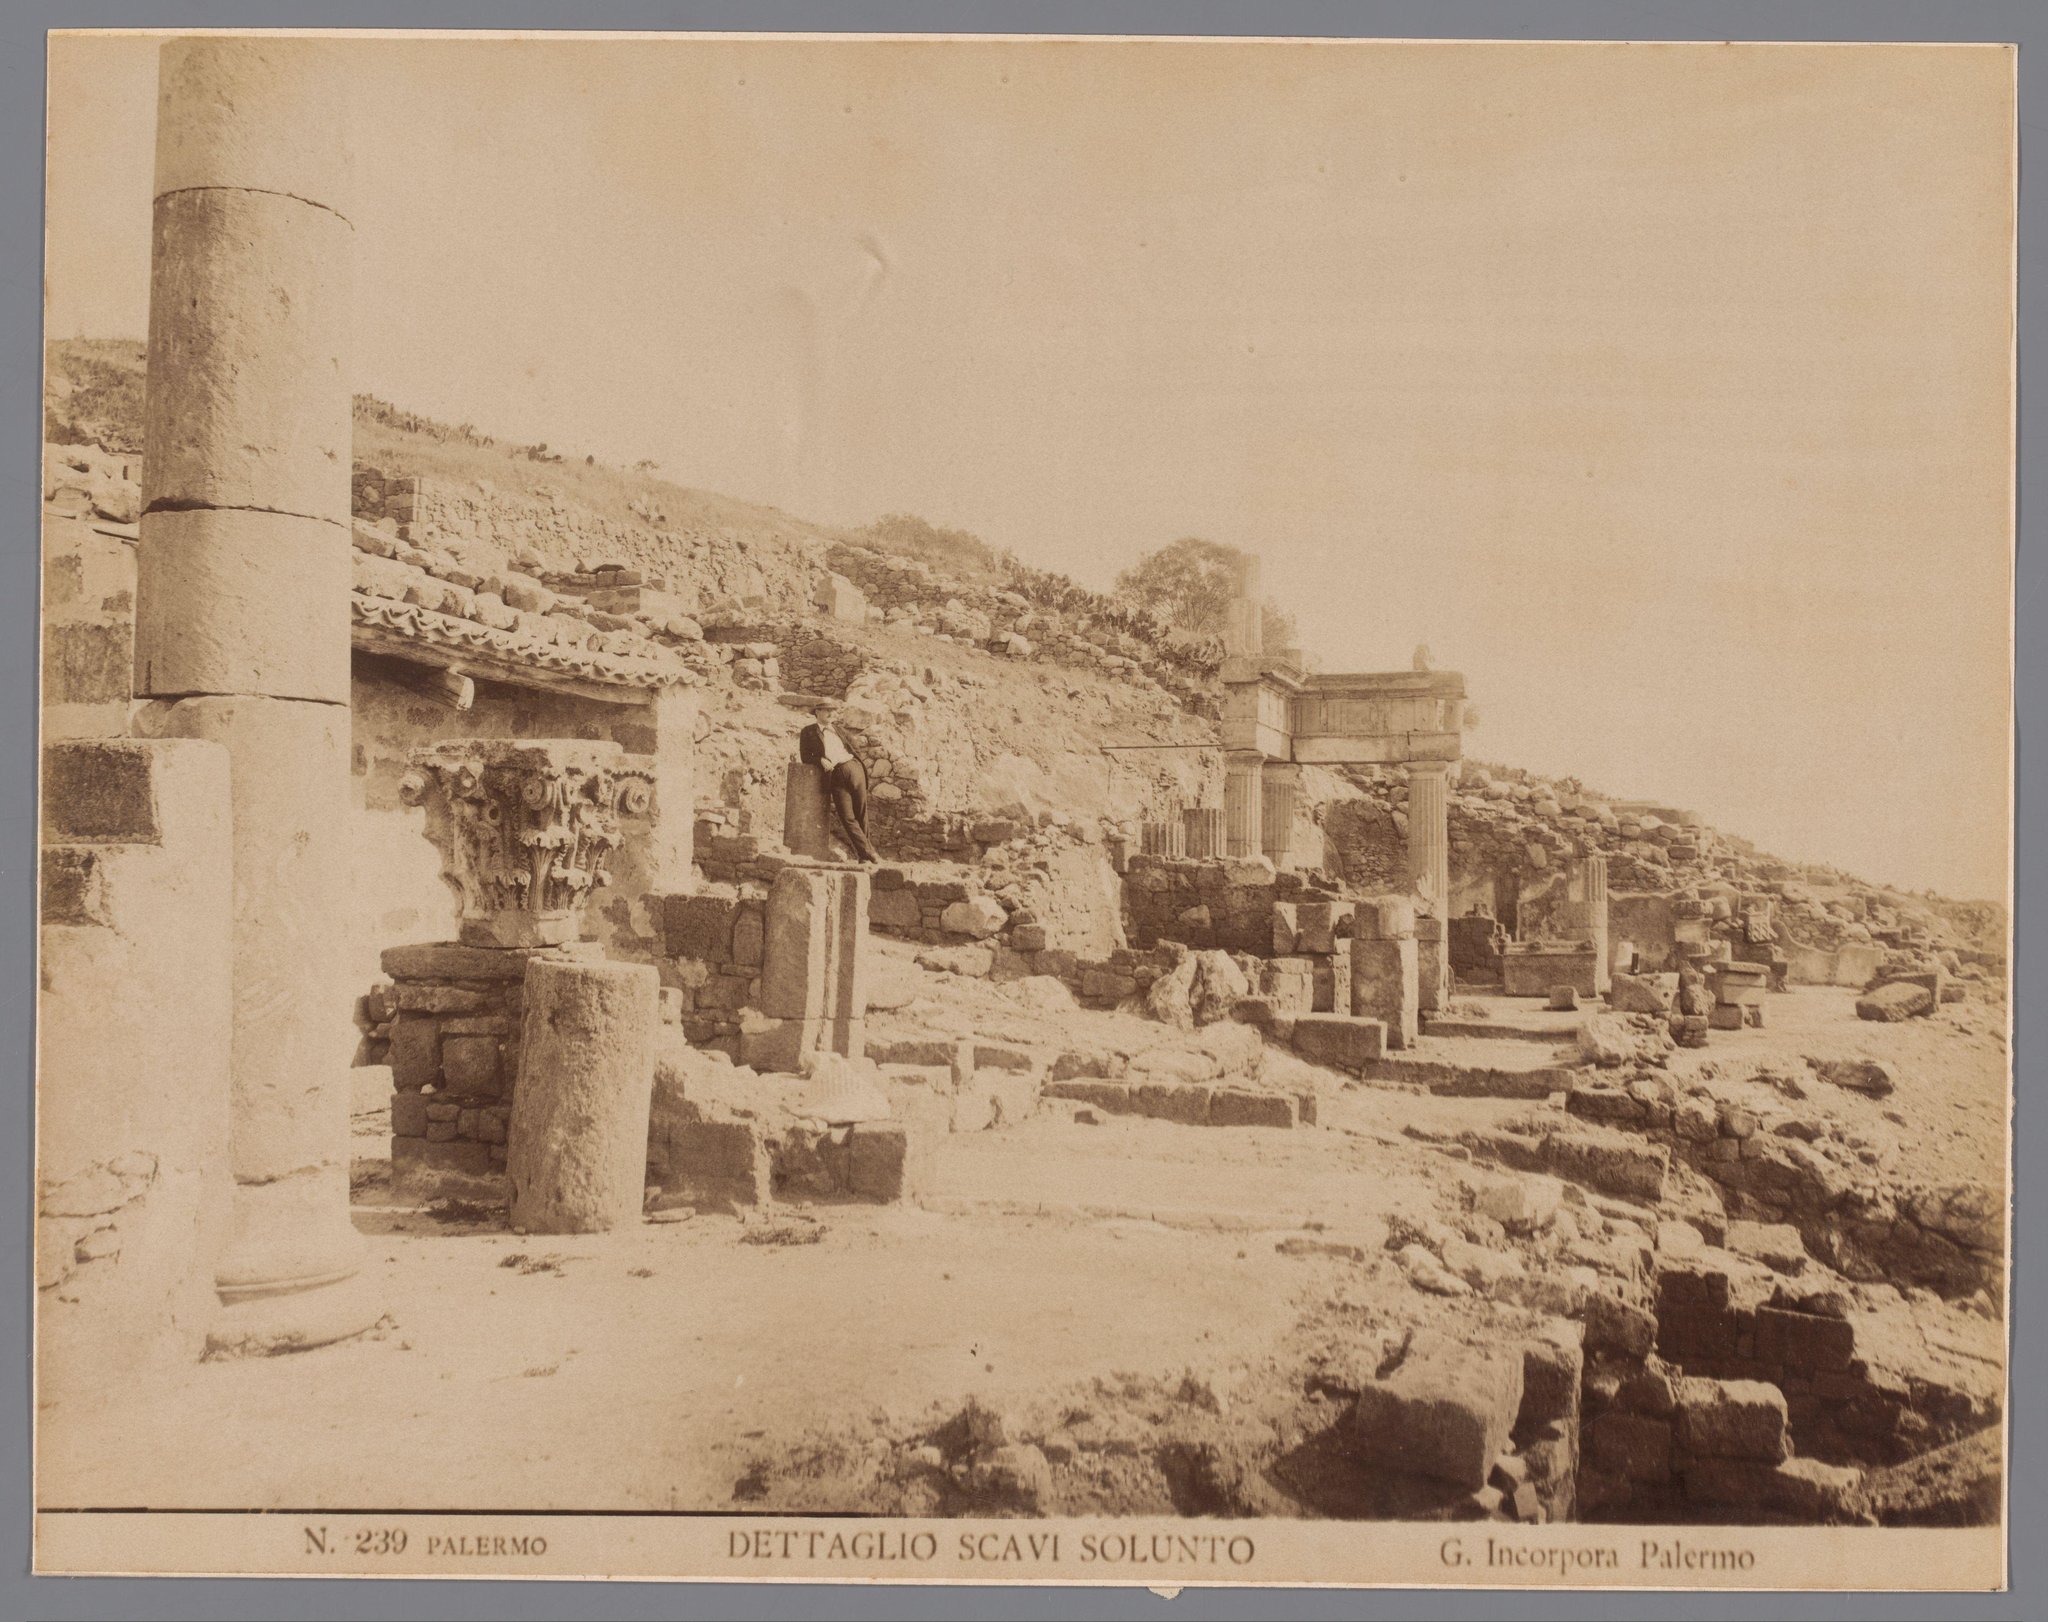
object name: photograph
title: Dettaglio scavi Solunto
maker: giuseppe incorpora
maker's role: fotograaf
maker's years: 1834-1914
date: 1856-1914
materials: cardboard, paper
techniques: albumen print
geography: palermo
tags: landscape with ruins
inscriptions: number: ‘N. 239’